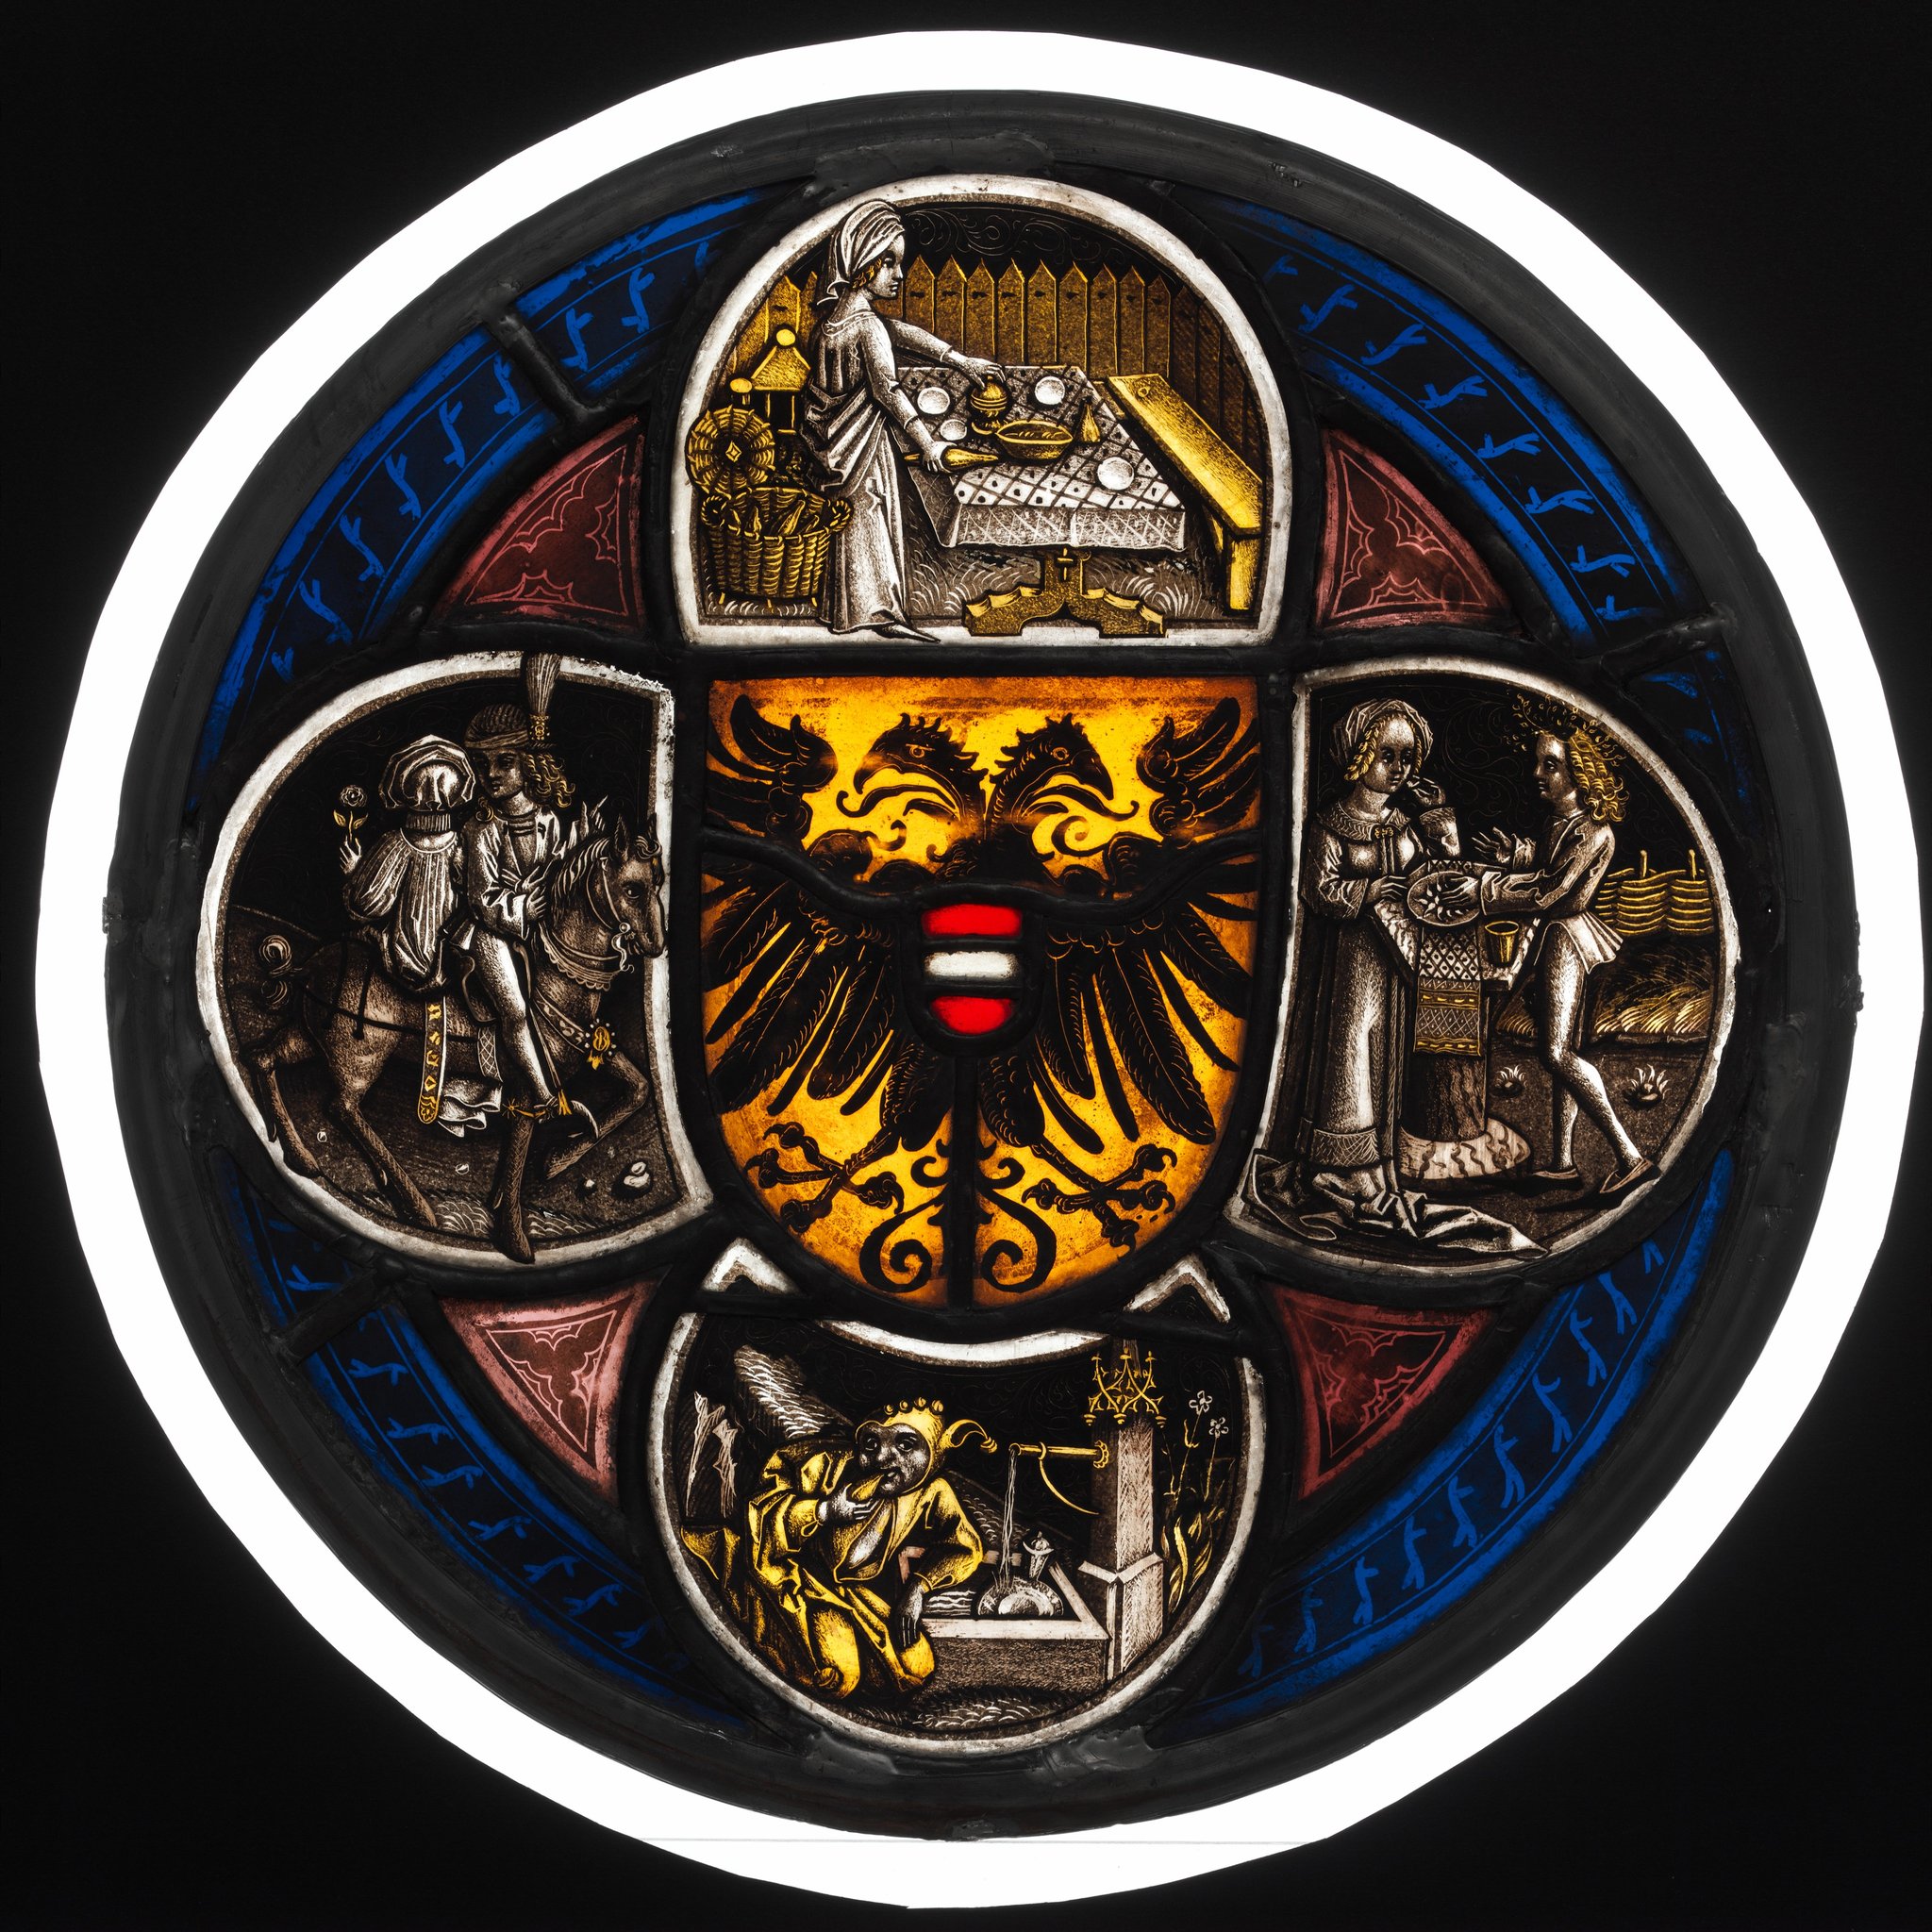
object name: roundel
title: Quatrefoil Roundel with Arms and Secular Scenes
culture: german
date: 1490-1500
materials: glass, metal, paint, pigment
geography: germany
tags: food,men,women,horses,coat of arms,tables